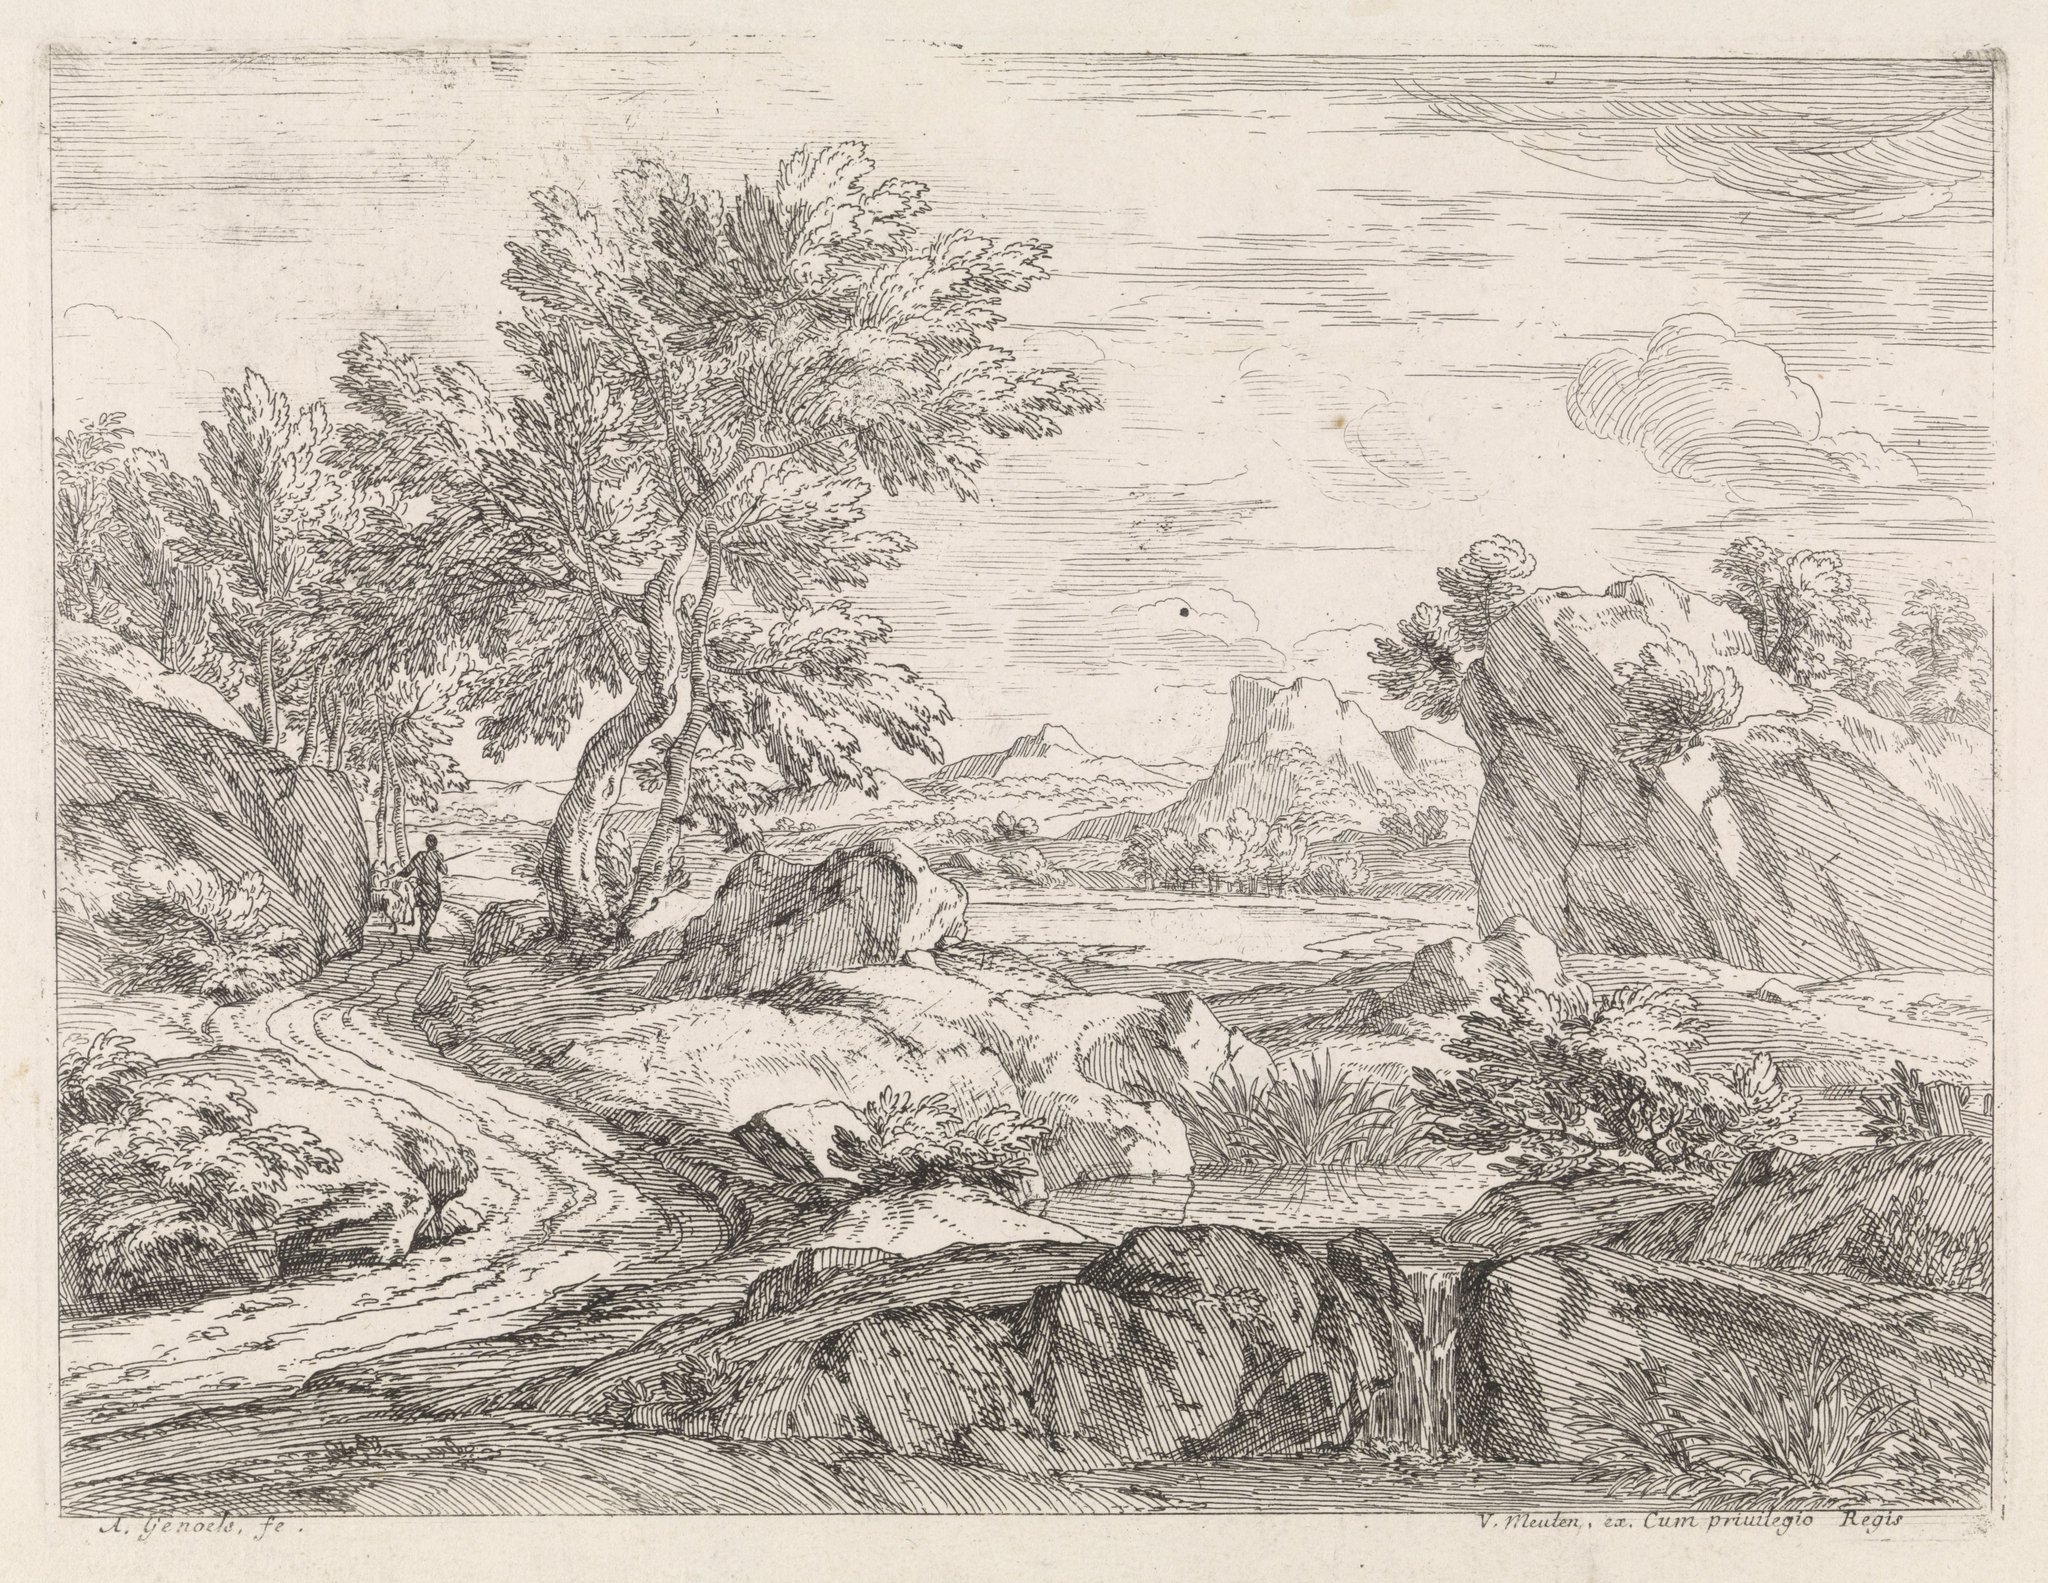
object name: print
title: Rivierlandschappen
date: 1650-1690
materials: paper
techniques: etching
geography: paris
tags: waterfall, brook, rock-formations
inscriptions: collector's mark: Lugt 240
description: Een landschap met rotsen en een weg. Naast de weg een kleine beek en een waterval. De prent maakt deel uit van een serie van rivierlandschappen.